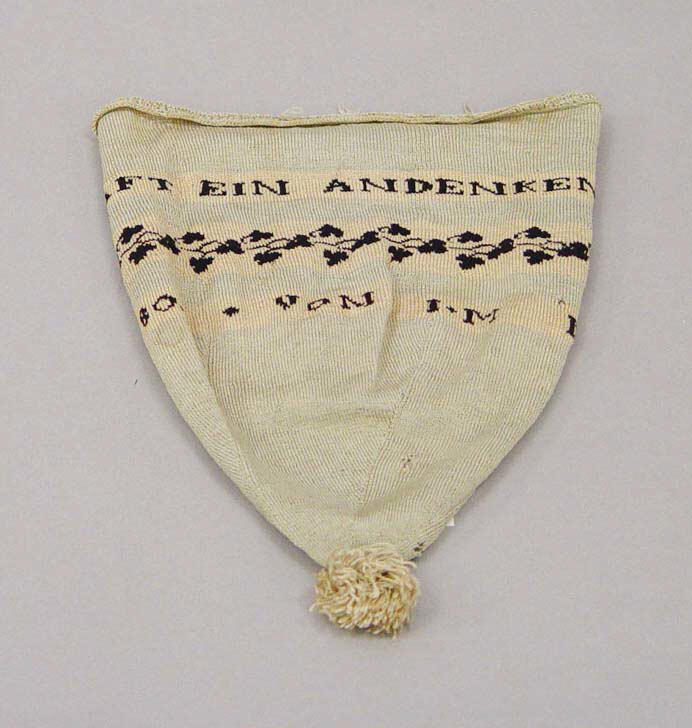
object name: cap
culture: austrian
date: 1805